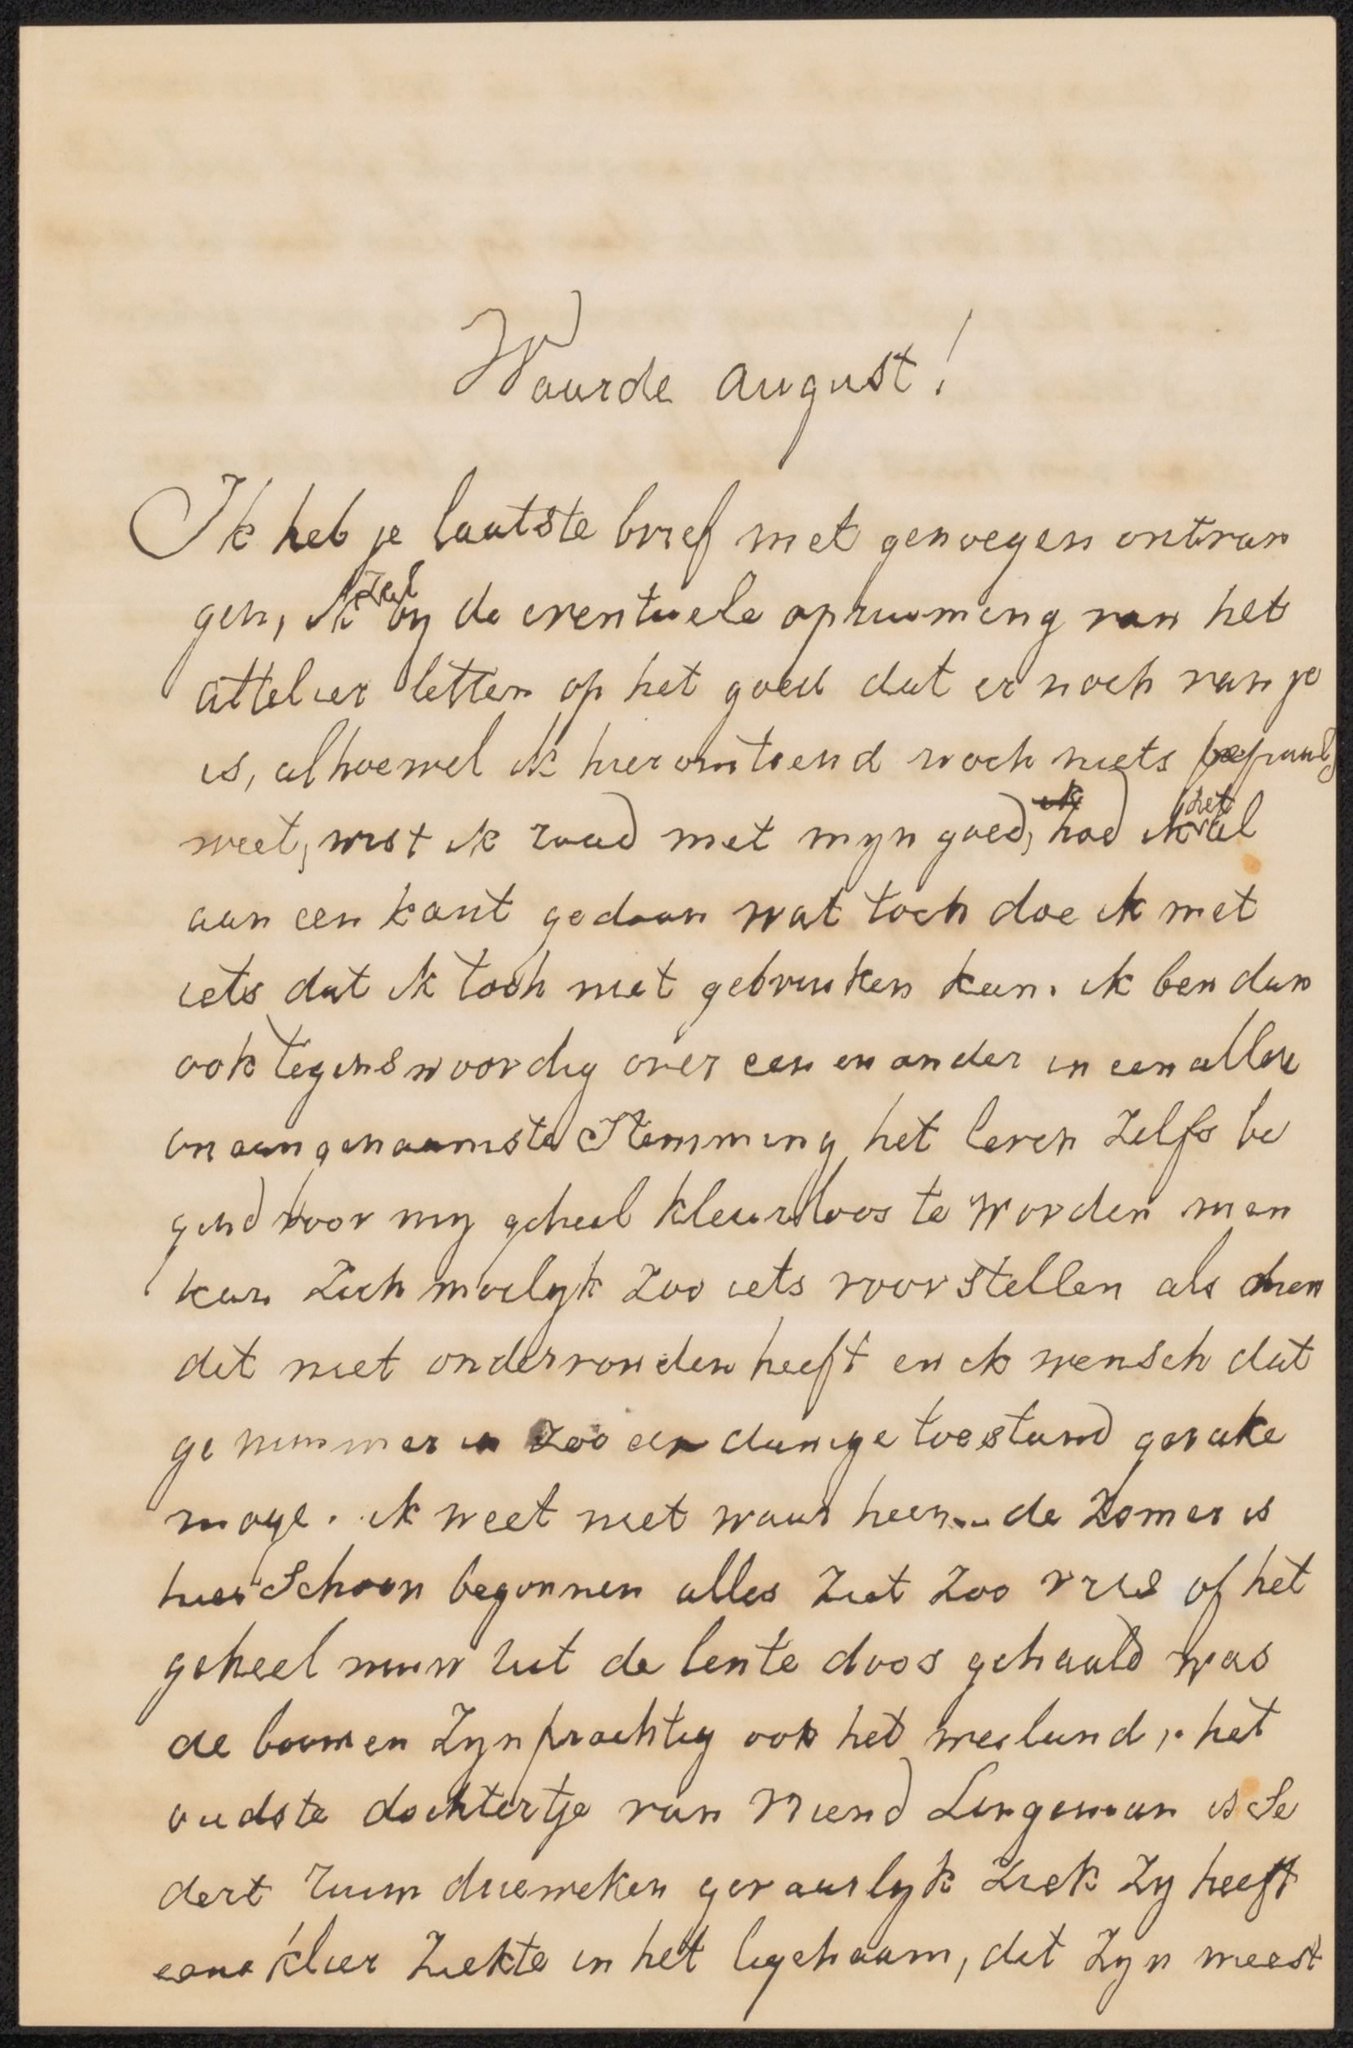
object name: letter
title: Brief aan August Allebé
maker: petrus franciscus greive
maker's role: draughtsman, print maker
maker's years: 1811-1872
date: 1869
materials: ink, paper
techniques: pen, writing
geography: amsterdam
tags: august allebé, jacob taanman, amsterdam, abcoude, painter, print maker, draughtsman, lambertus lingeman, joan berg, passions, emotions, affections, workshop, studio of the artist (in general), exhibition ~ art, diseases